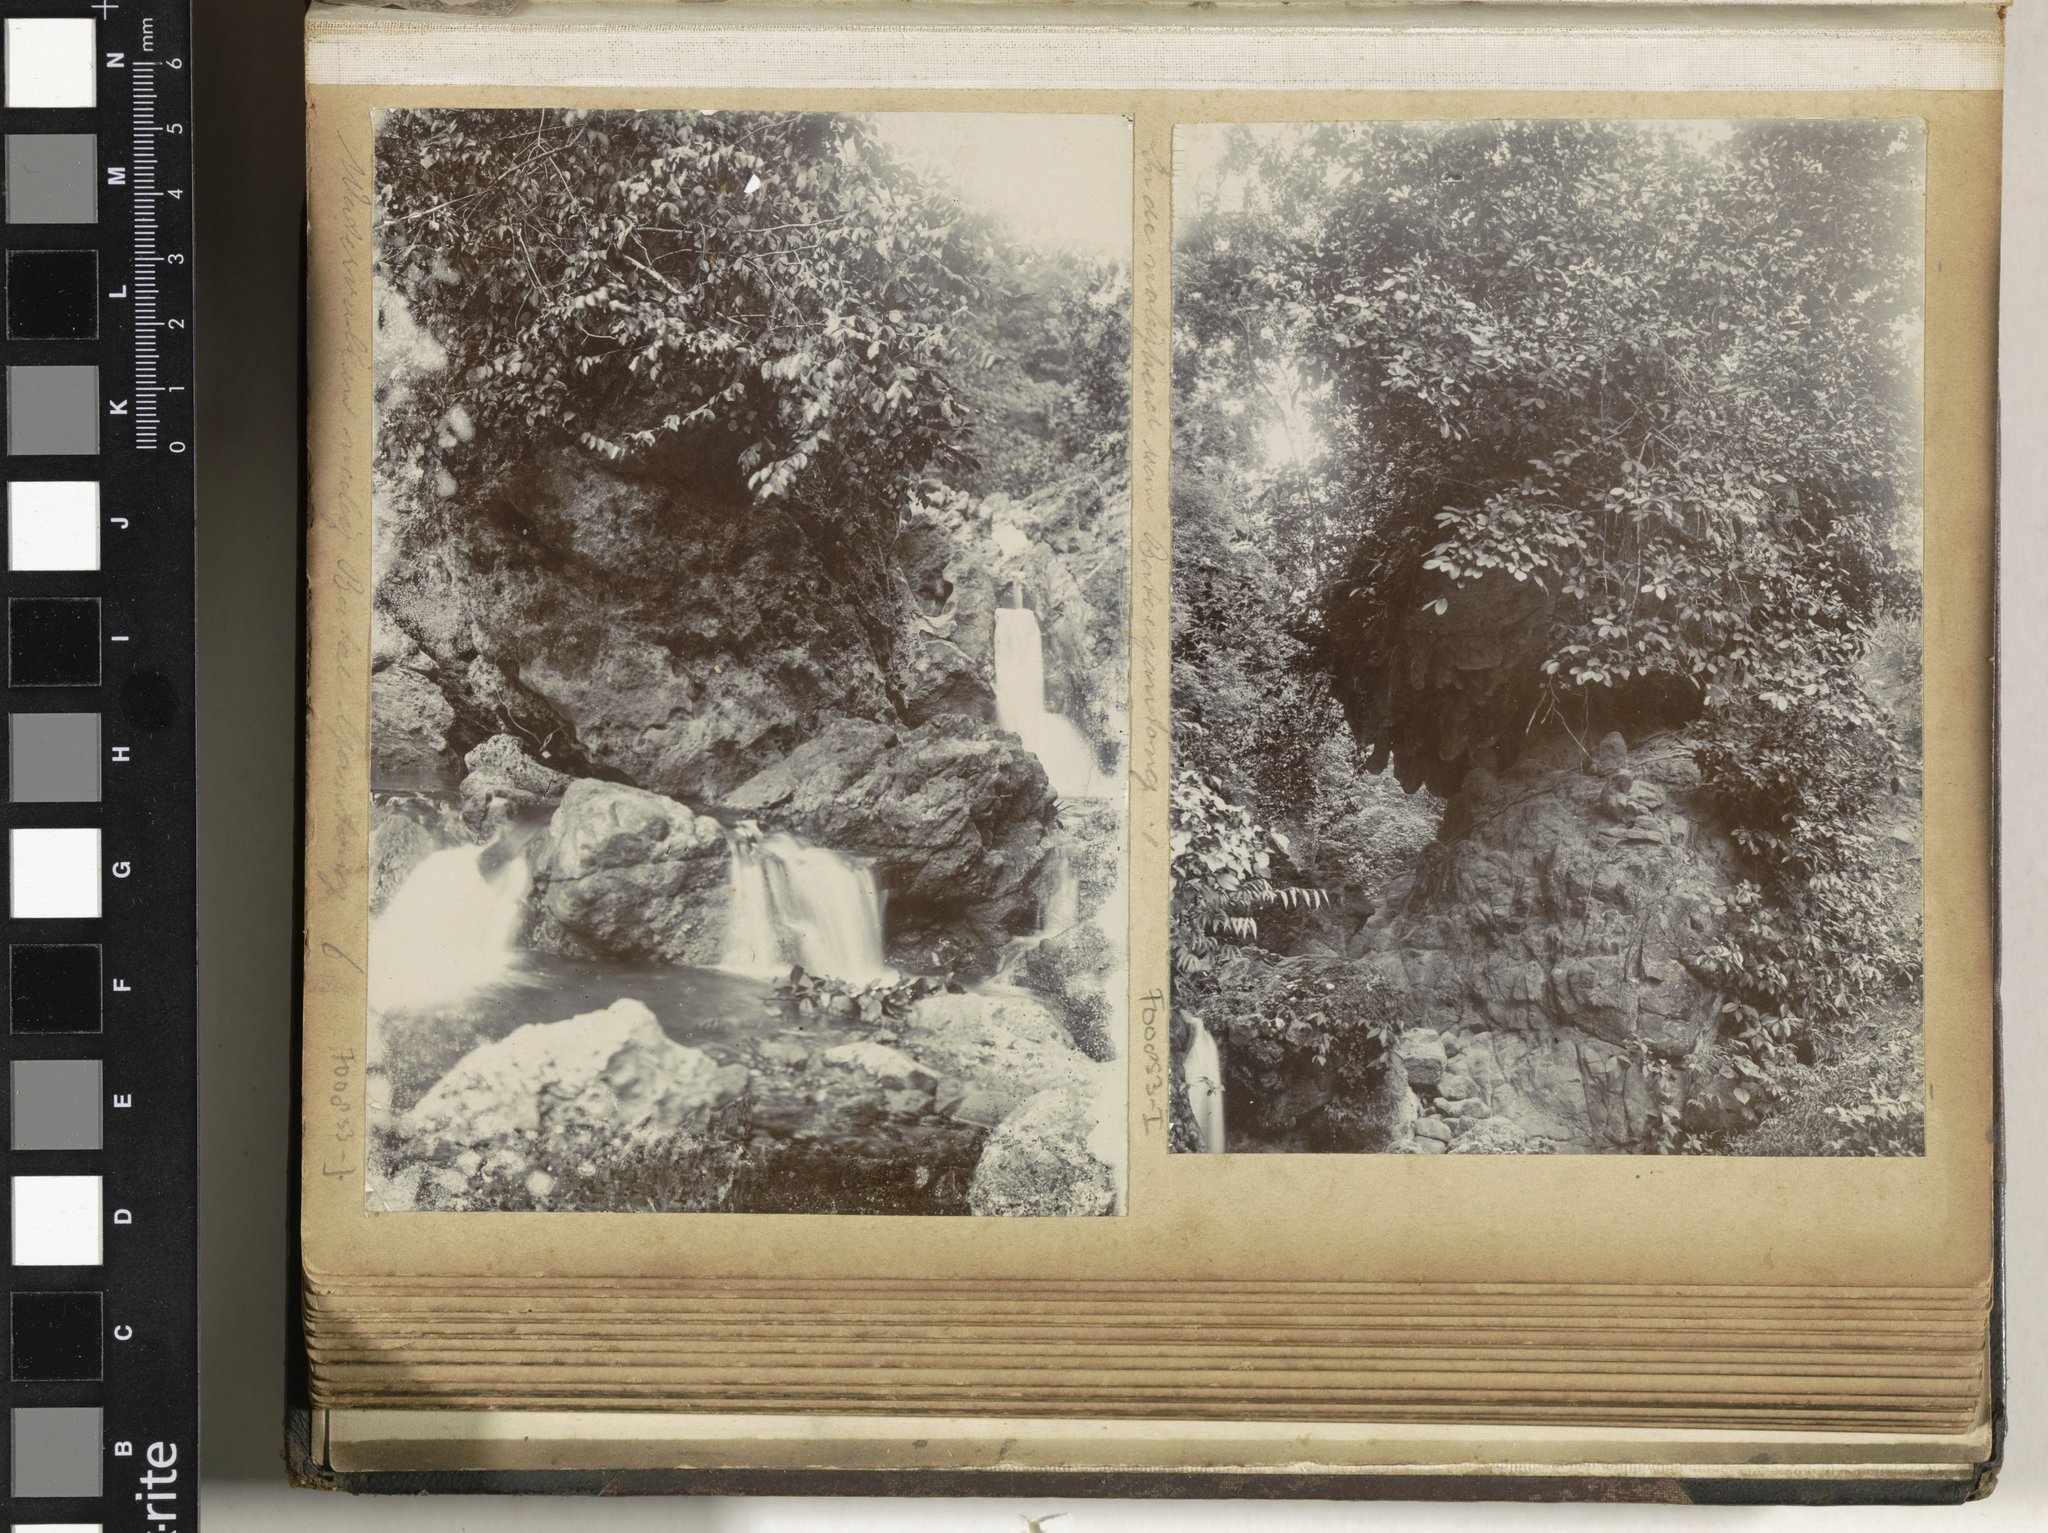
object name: album leaf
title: In de nabijheid van Batoe gantong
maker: Anonymous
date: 1900-1920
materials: cardboard, paper, photographic support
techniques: gelatin silver print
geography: ambon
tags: rocks (+ landscape with figures, staffage), dutch east indies, the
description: Onderdeel van Reisalbum met foto's van Ambon.